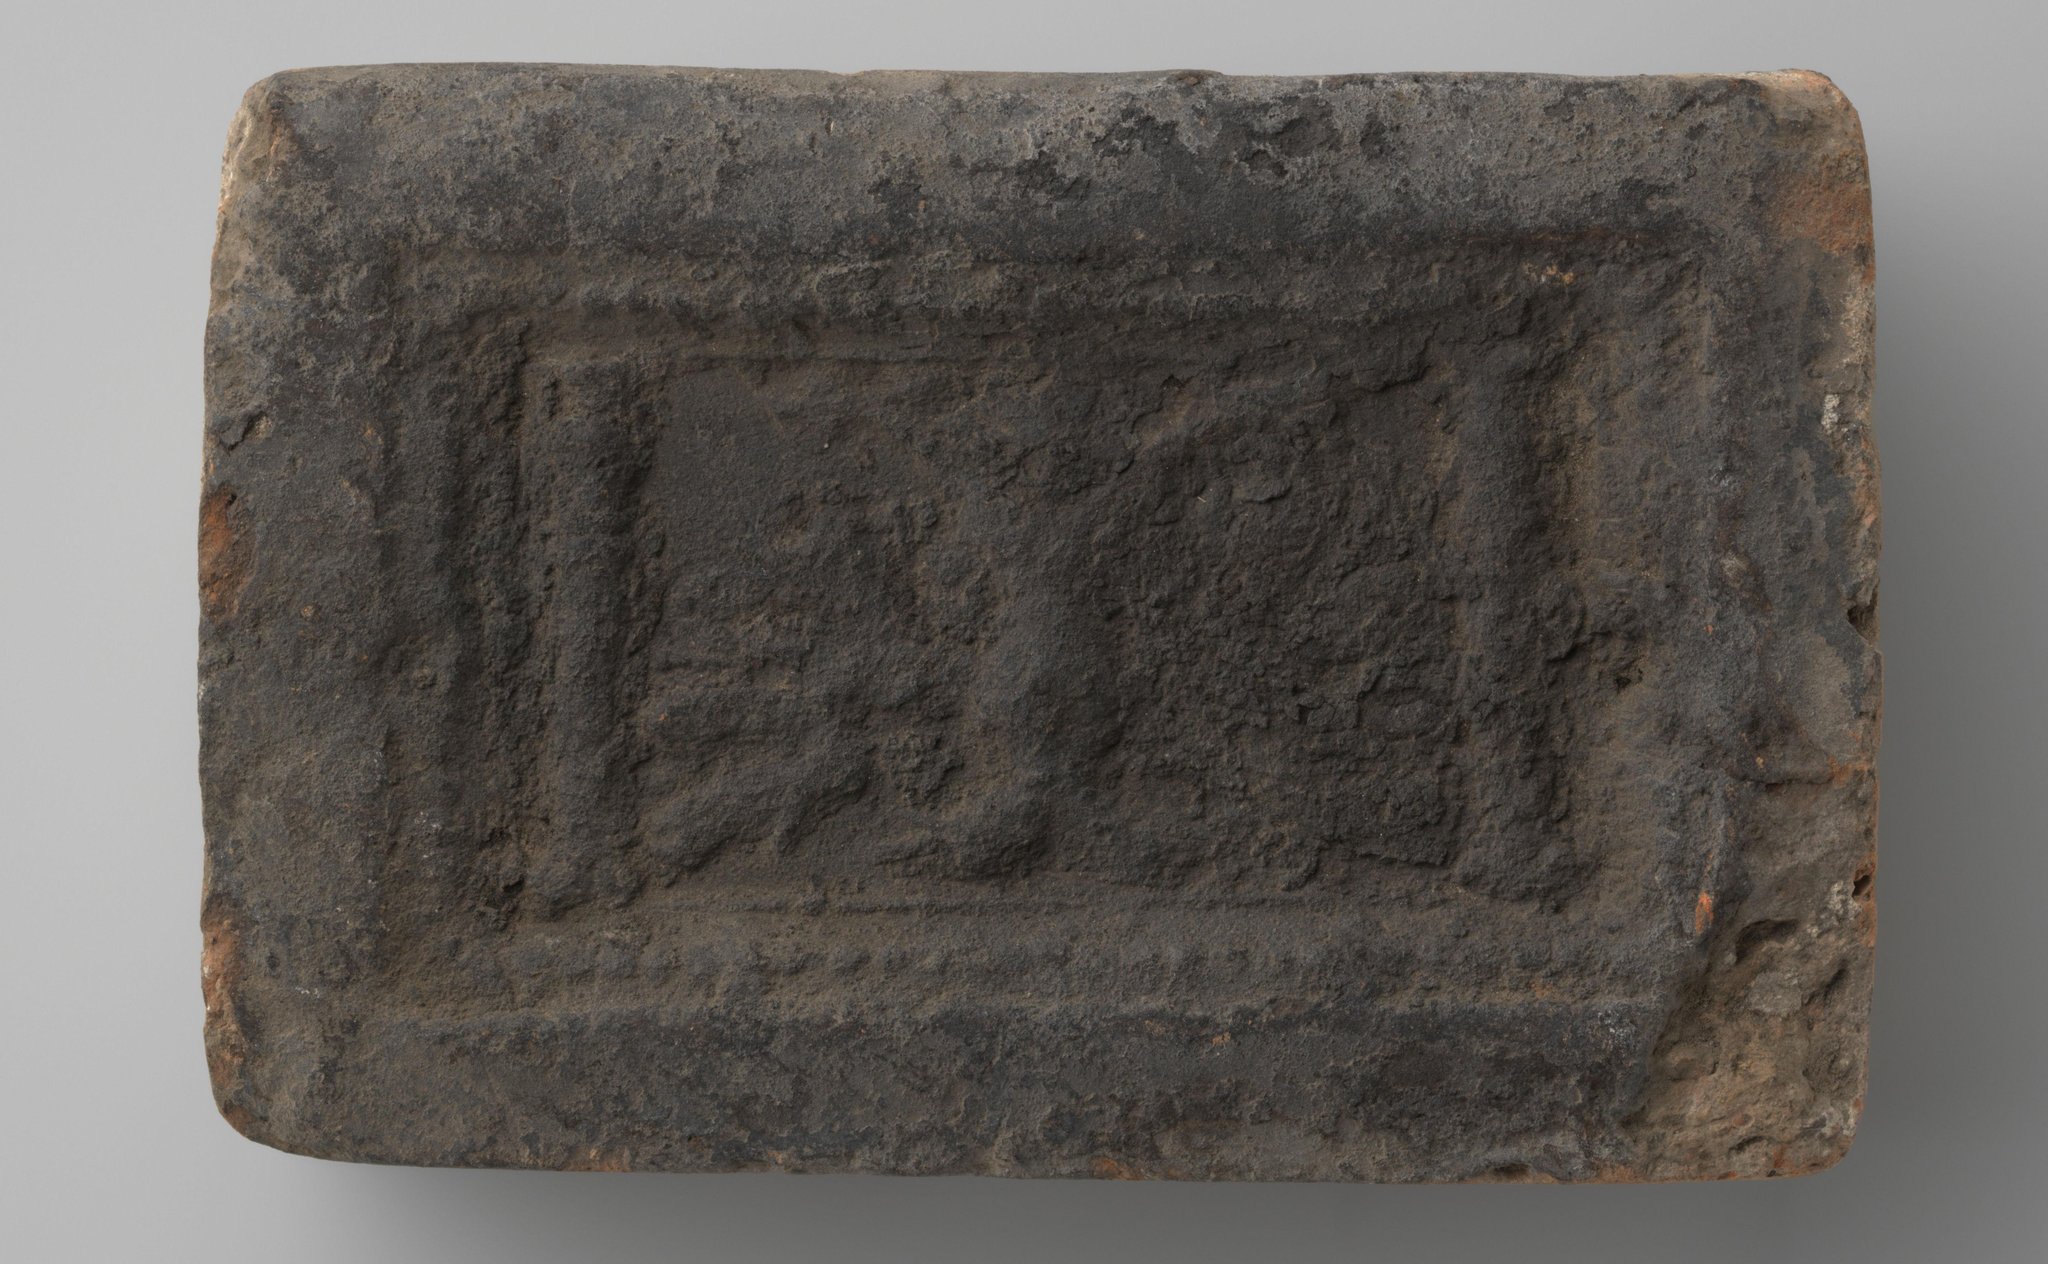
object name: hearthstone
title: Haardsteen met voorstelling van de tweekoppige adelaar tussen de zuilen van Hercules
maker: Anonymous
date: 1550-1600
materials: earthenware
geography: southern netherlands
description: Haardsteen met voorstelling van de tweekoppige adelaar tussen de zuilen van Hercules.